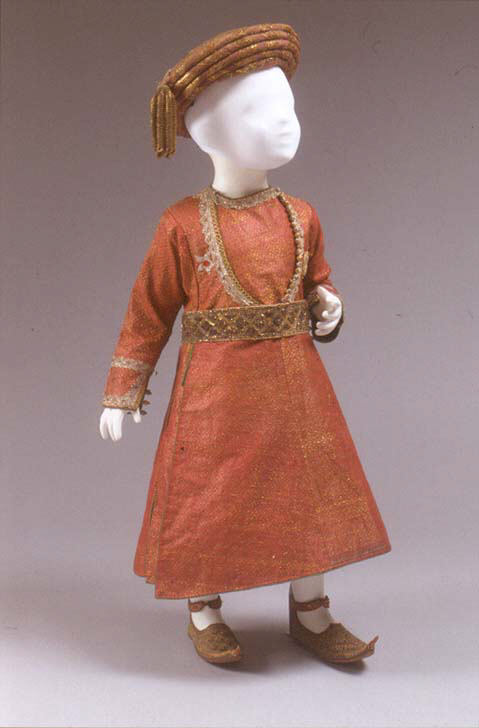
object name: ensemble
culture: indian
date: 1815-1820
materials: cotton, glass, silk